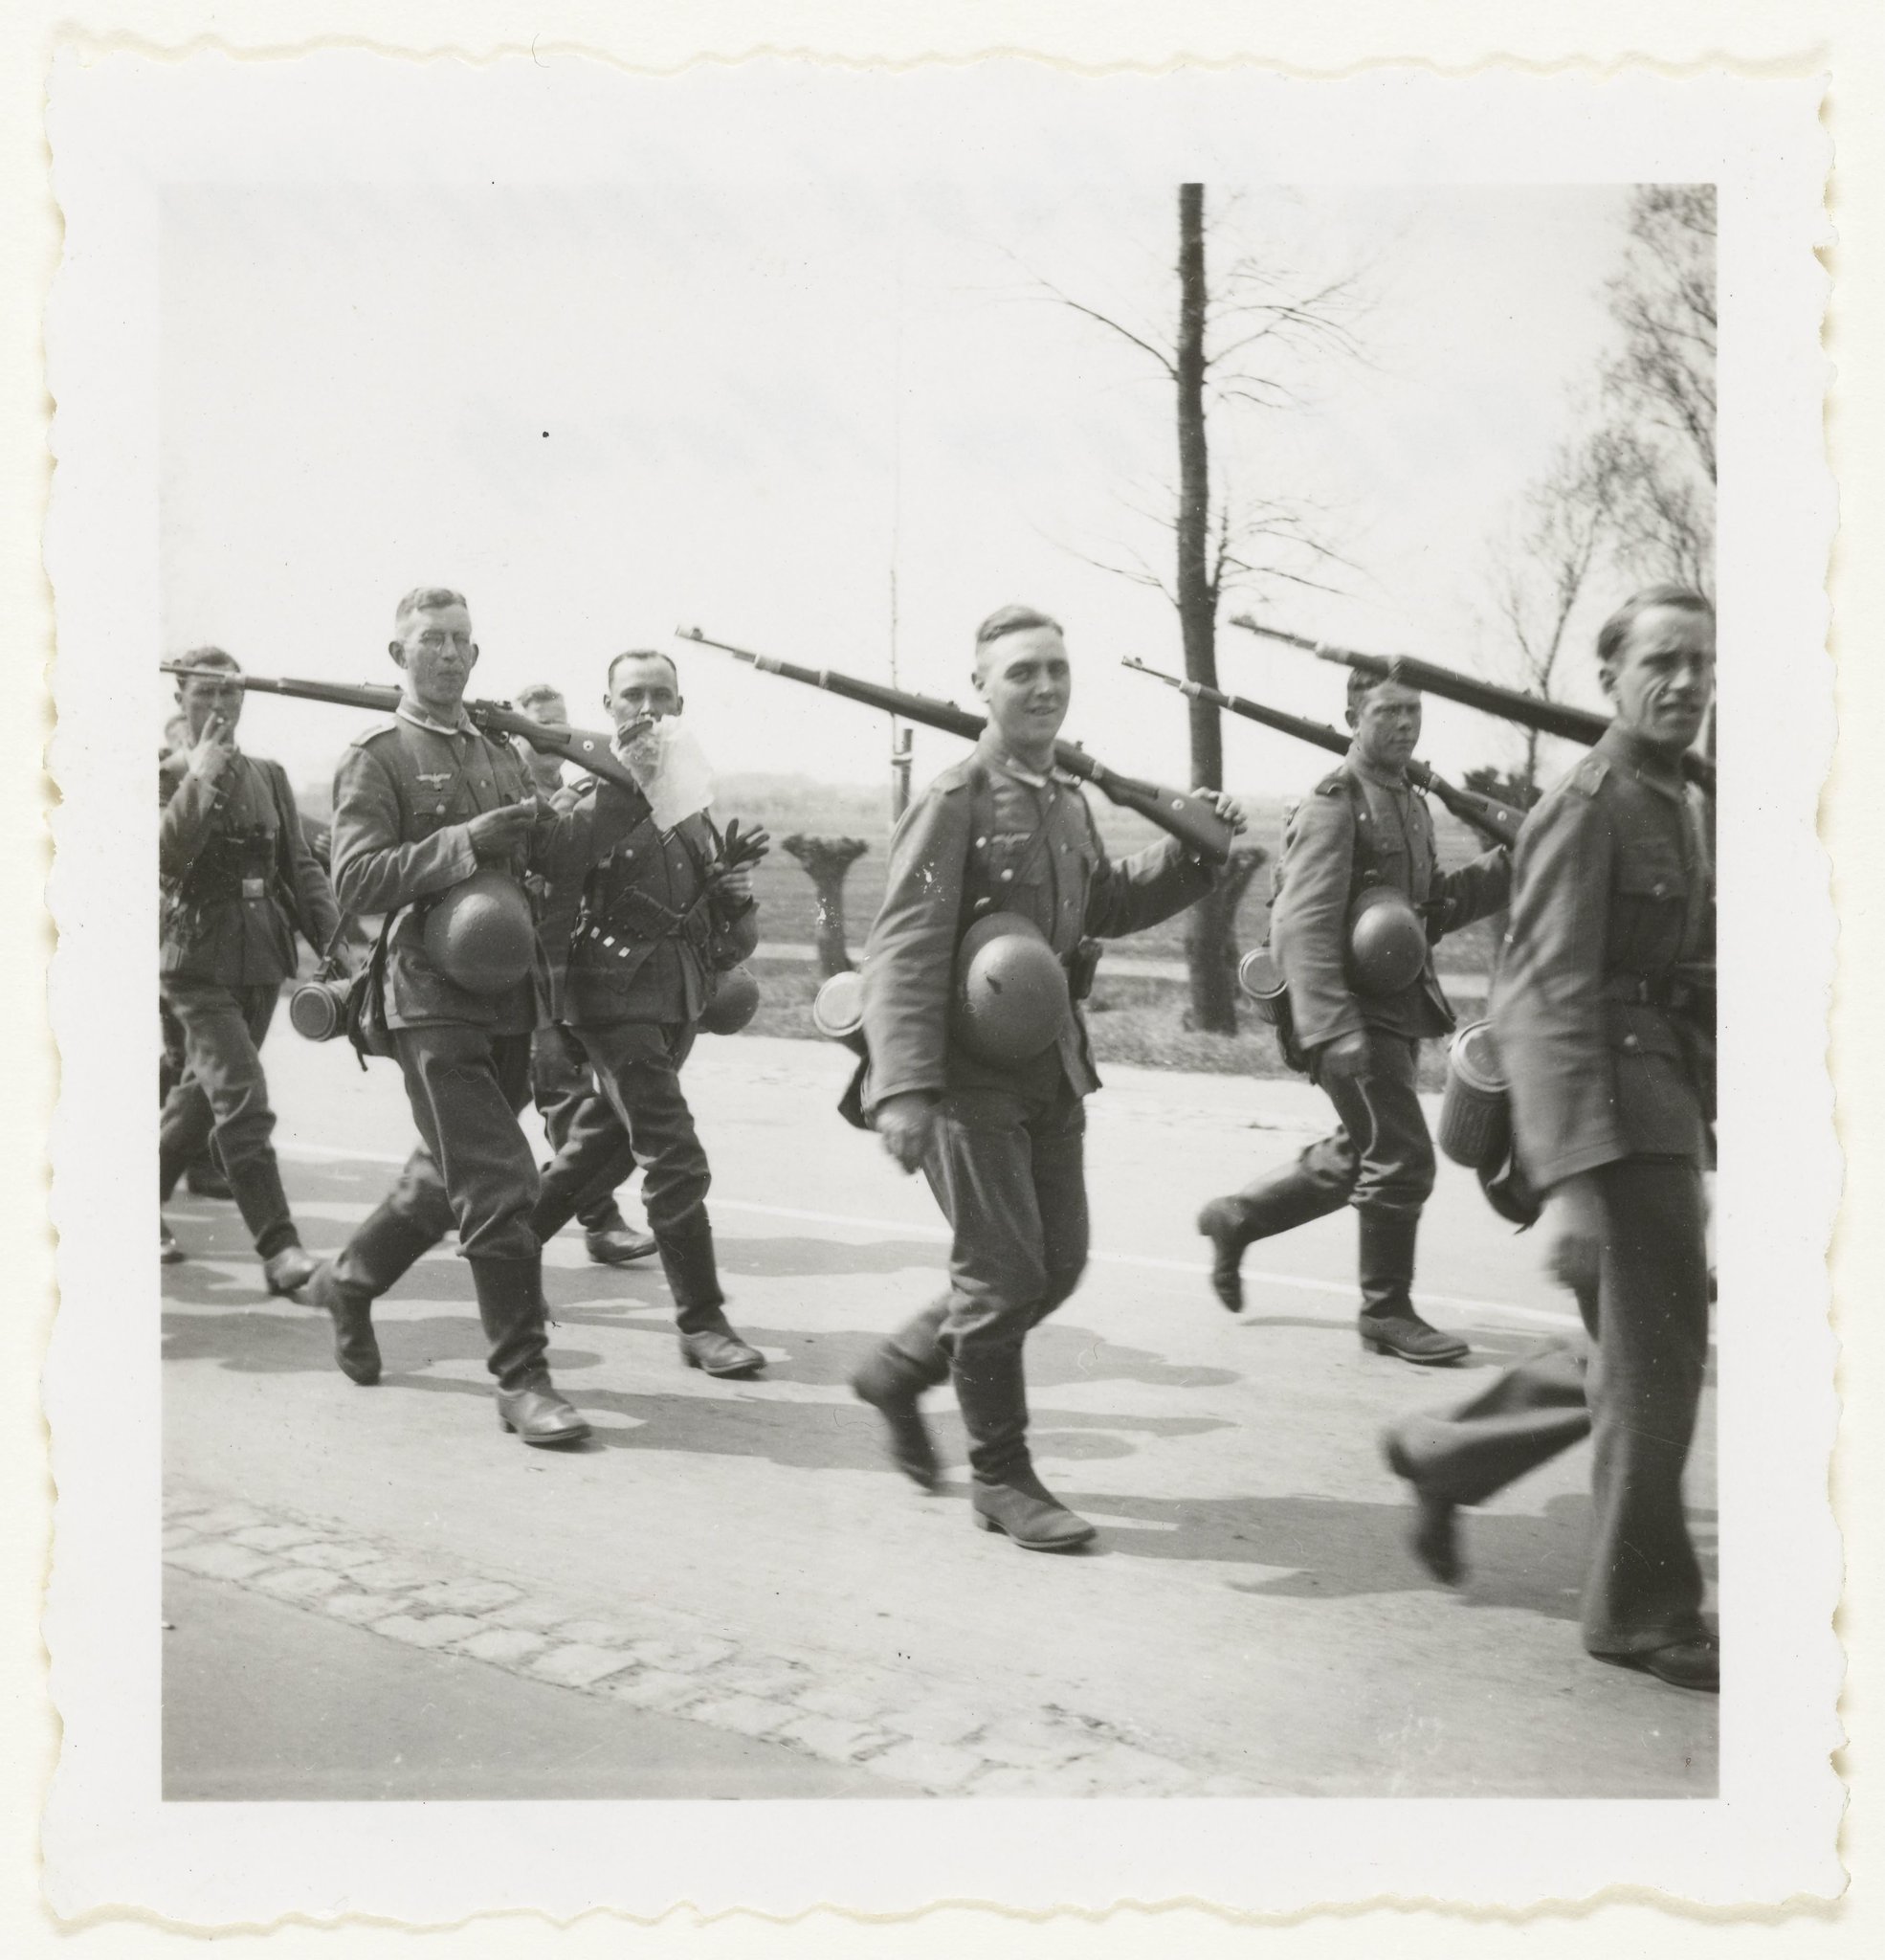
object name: photograph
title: Colonne Duitse soldaten op mars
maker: Anonymous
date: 1904-1941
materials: photographic support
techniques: gelatin silver print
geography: netherlands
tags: army 'en route', occupation ~ war, netherlands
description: Een colonne Duitse soldaten op mars. Ze dragen geweren over hun schouder en zijn blootshoofd. Achterop staat: In Holland April 1941. Auf dem Marsch.